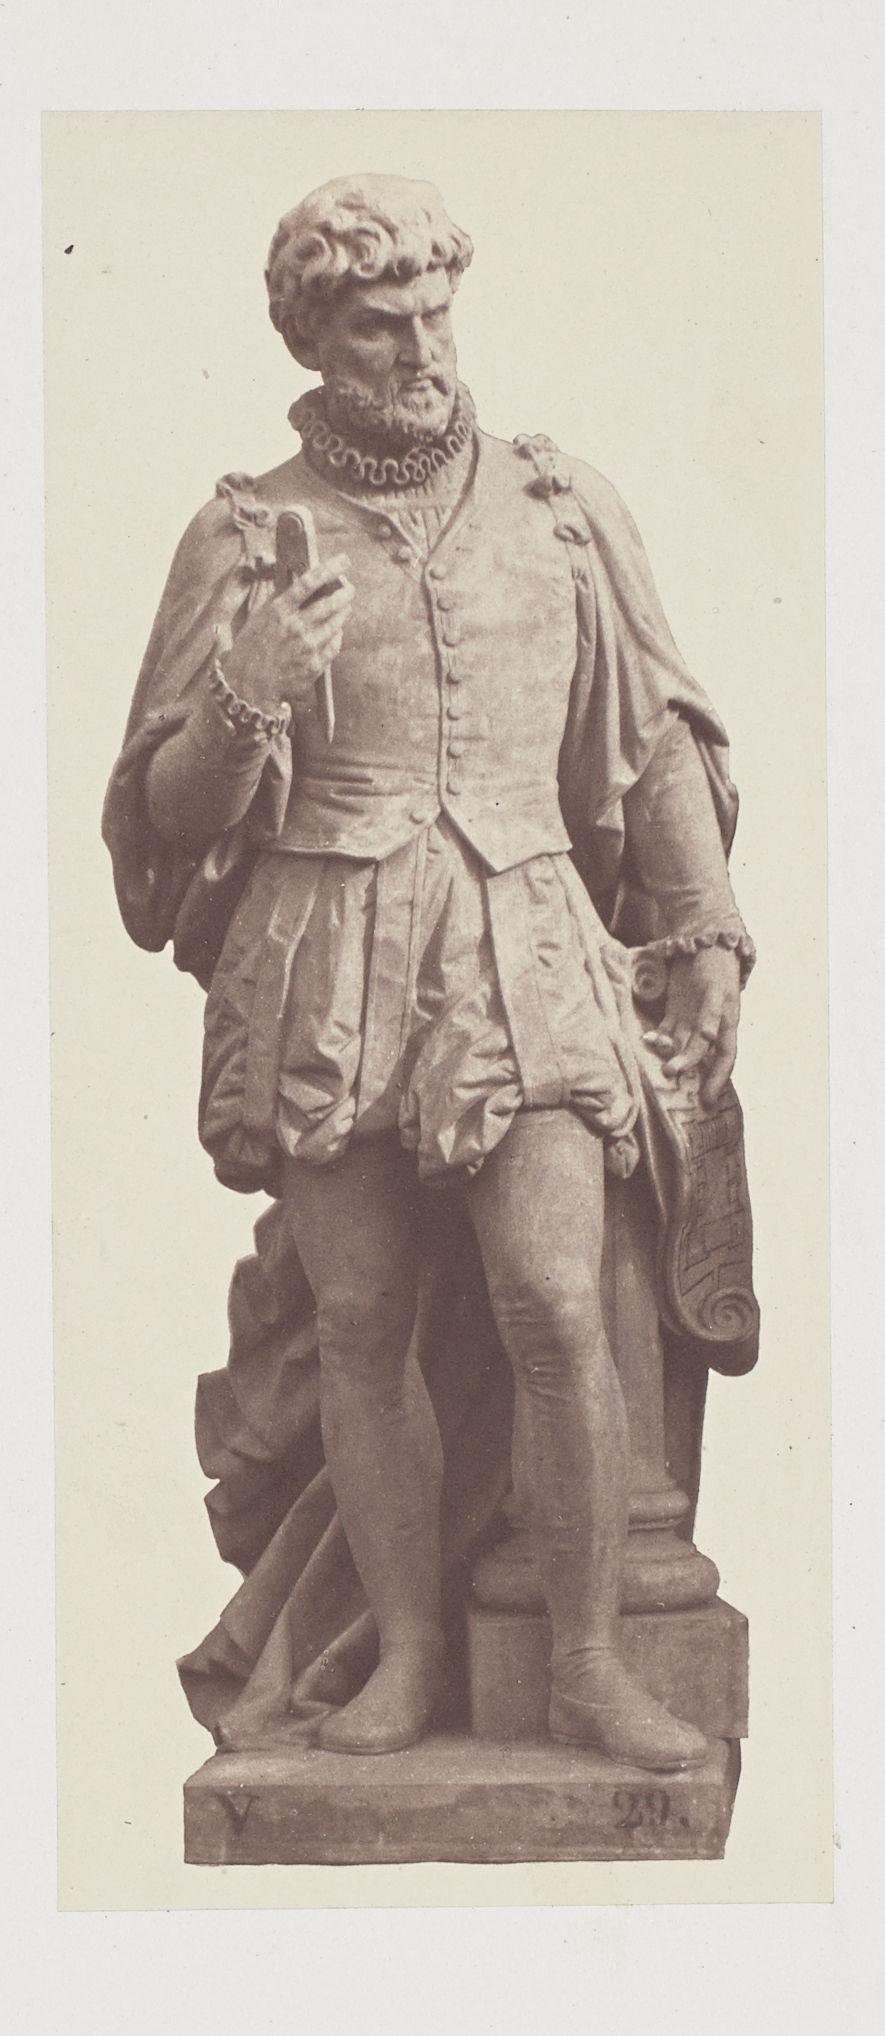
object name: album leaf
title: Gipsmodellen voor beeldhouwwerken op het Palais du Louvre: links "Lescot" door Henri Joseph François de Triqueti en rechts "Bullant" door Pierre Alfred Robinet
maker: édouard denis baldus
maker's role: fotograaf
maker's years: 1813-1889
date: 1855-1857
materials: paper, photographic support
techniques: salted paper print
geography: paris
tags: piece of sculpture, reproduction of a piece of sculpture, permanent exhibition, museum, paris, tuileries palace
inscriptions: number: ‘33 en V 29’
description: Onderdeel van Réunion des Tuileries au Louvre 1852-1857, album 2.